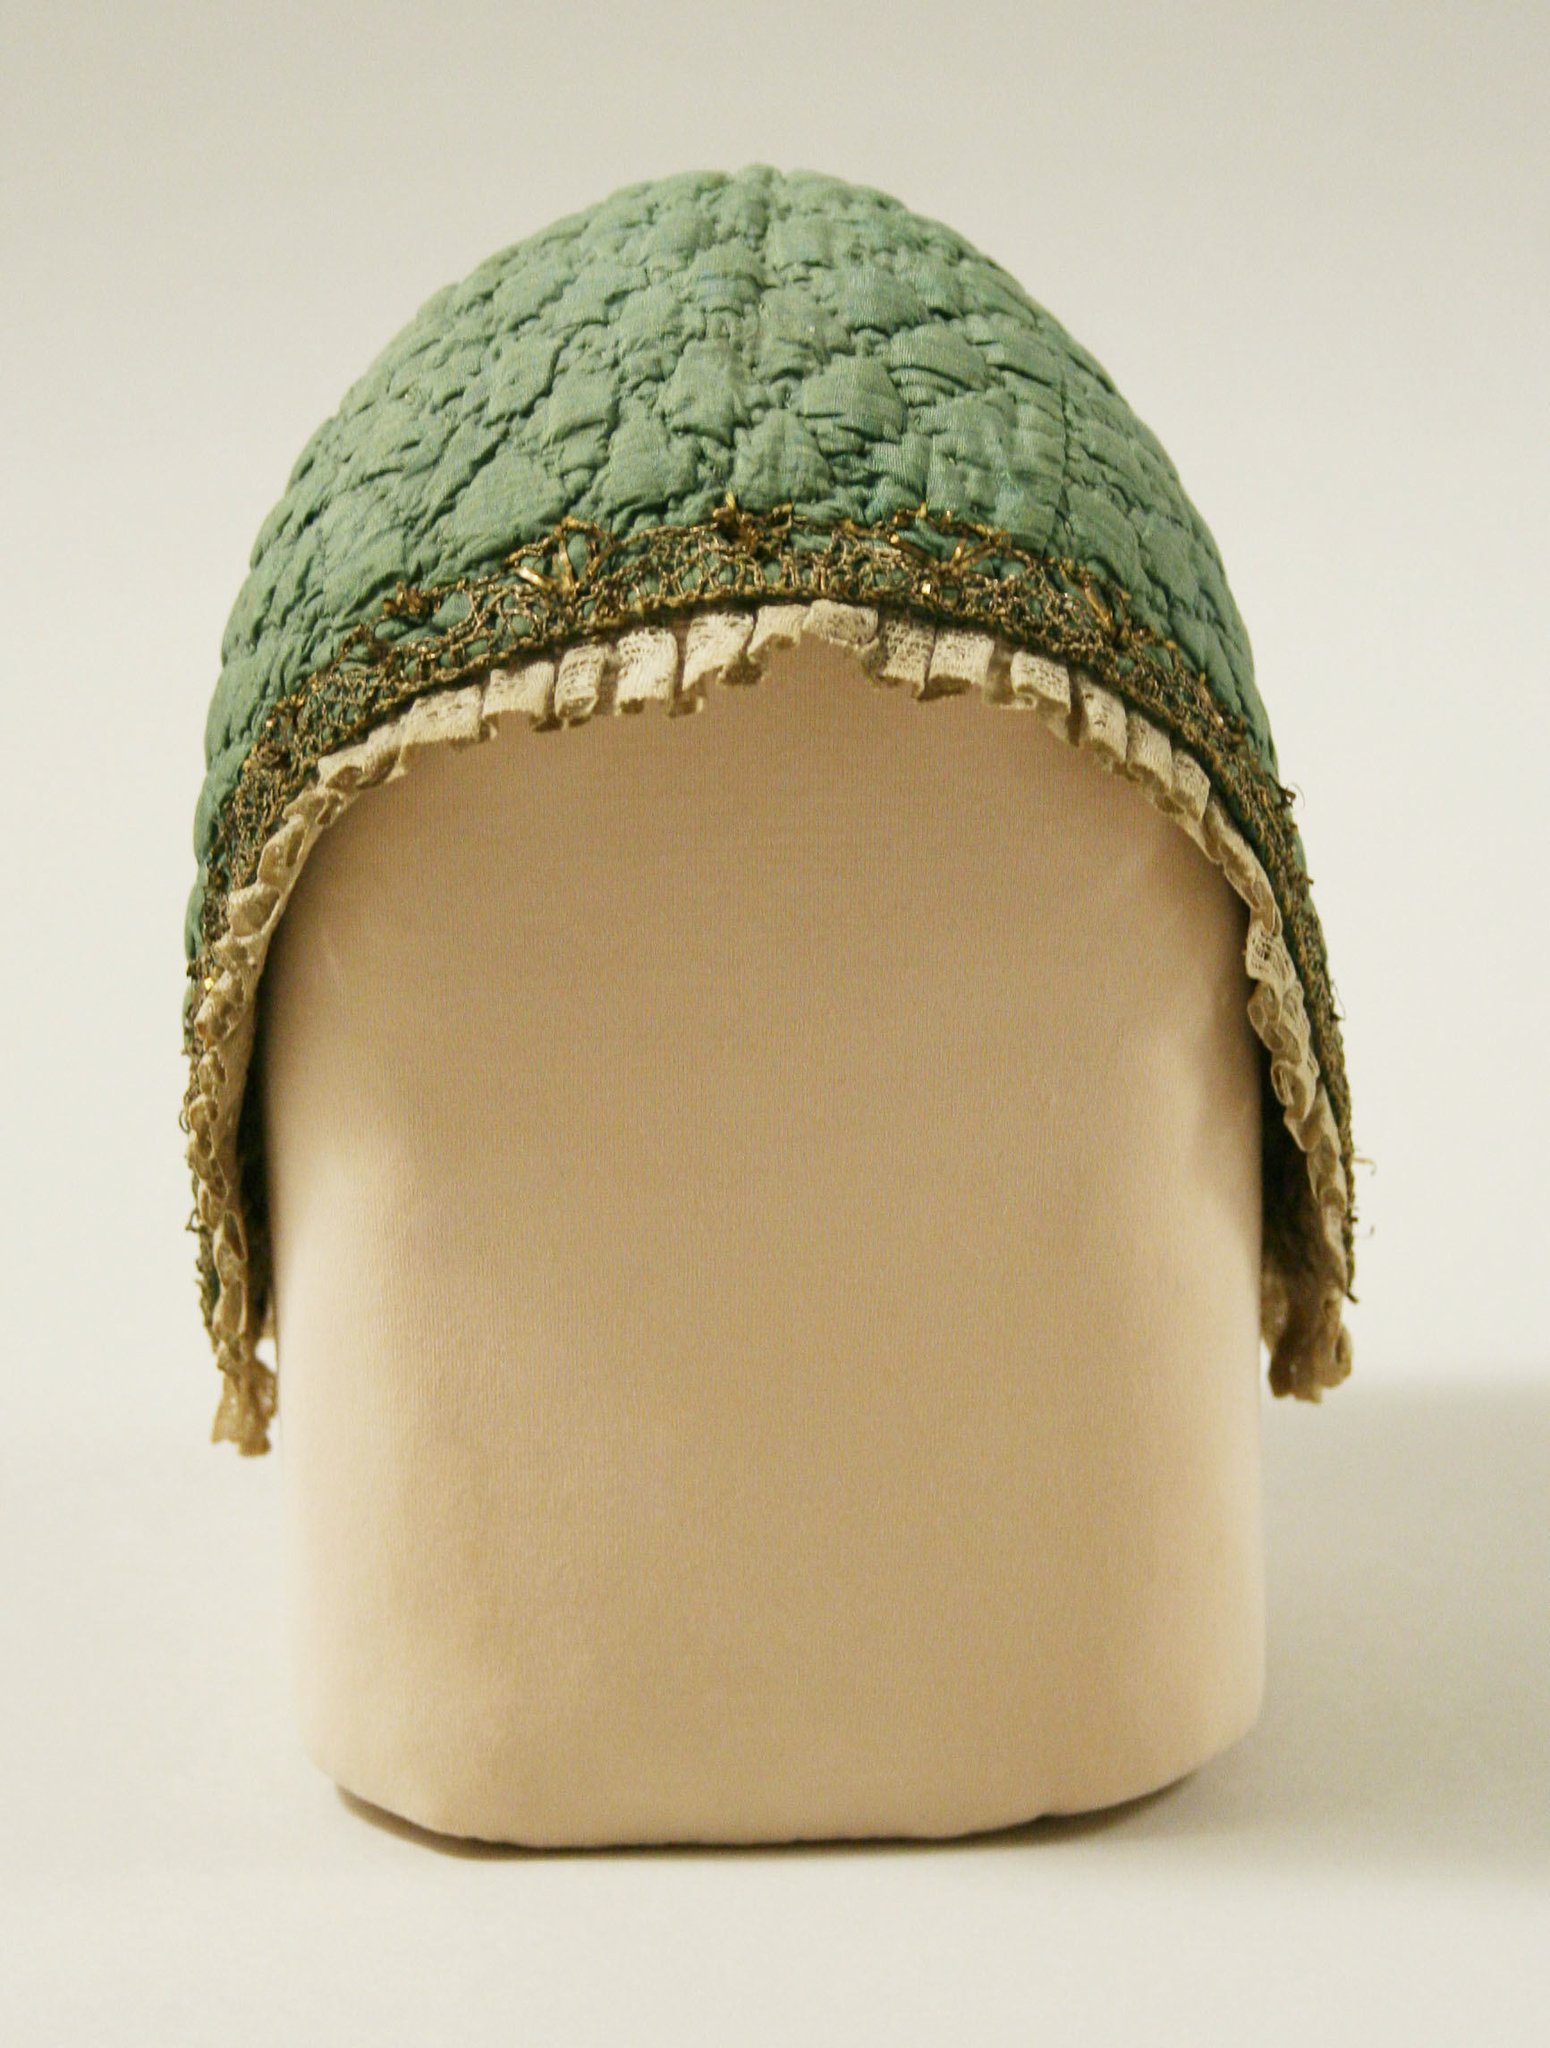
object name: cap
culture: french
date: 1701-1800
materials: cotton, silk